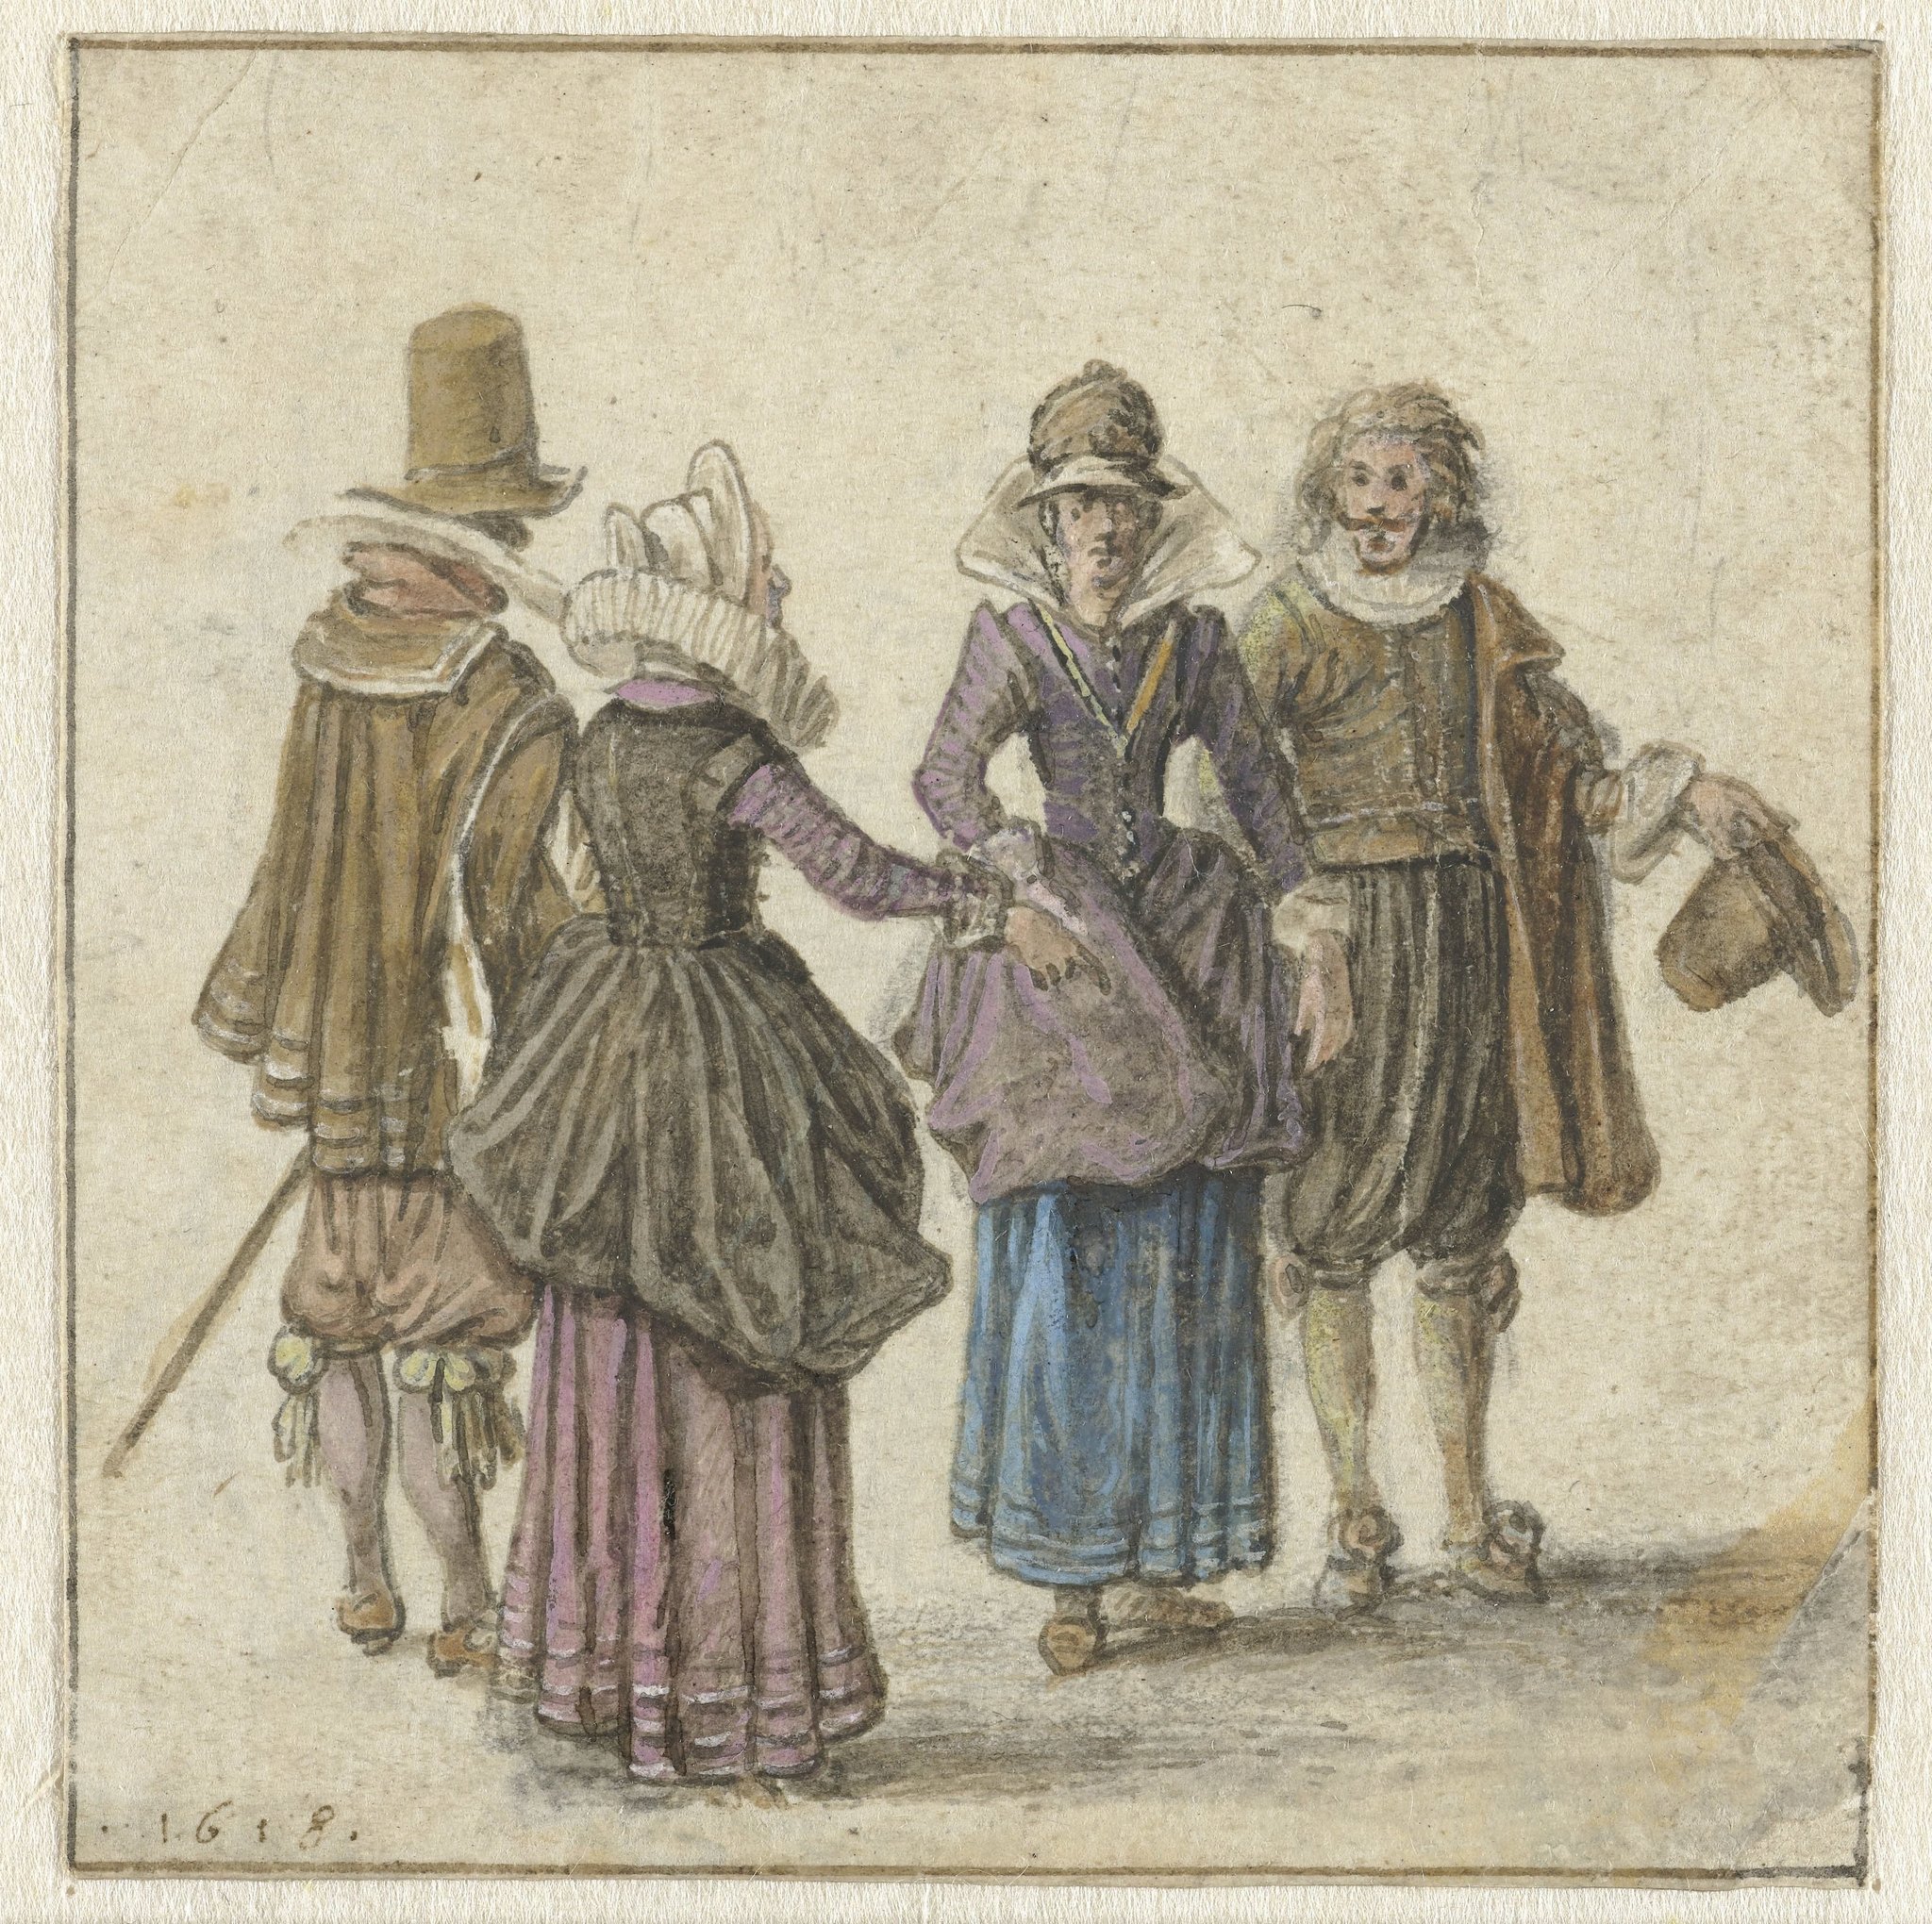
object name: drawing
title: Two Well-dressed Couples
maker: adriaen pietersz van de venne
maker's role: draughtsman, painter, print maker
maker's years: 1589-1662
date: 1618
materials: chalk, ink, paper, watercolor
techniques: brush, drawing, pen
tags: black velvet or satin mask, 'loup', 'cachenez' (+ women's clothes), baring the head, lifting one's hat, coat (+ men's clothes), head-gear: hat (+ men's clothes), head-gear: cap (+ women's clothes), neck-gear ~ clothing (with name) (+ women's clothes), skirt (+ women's clothes), dress, gown (+ women's clothes), shoes, sandals (+ men's clothes), neck-gear: collar (+ men's clothes), meeting, trousers, breeches, etc. (breeches) (+ men's clothes), stockings, socks (+ men's clothes)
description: Twee modieus geklede paren, elkaar groetend.